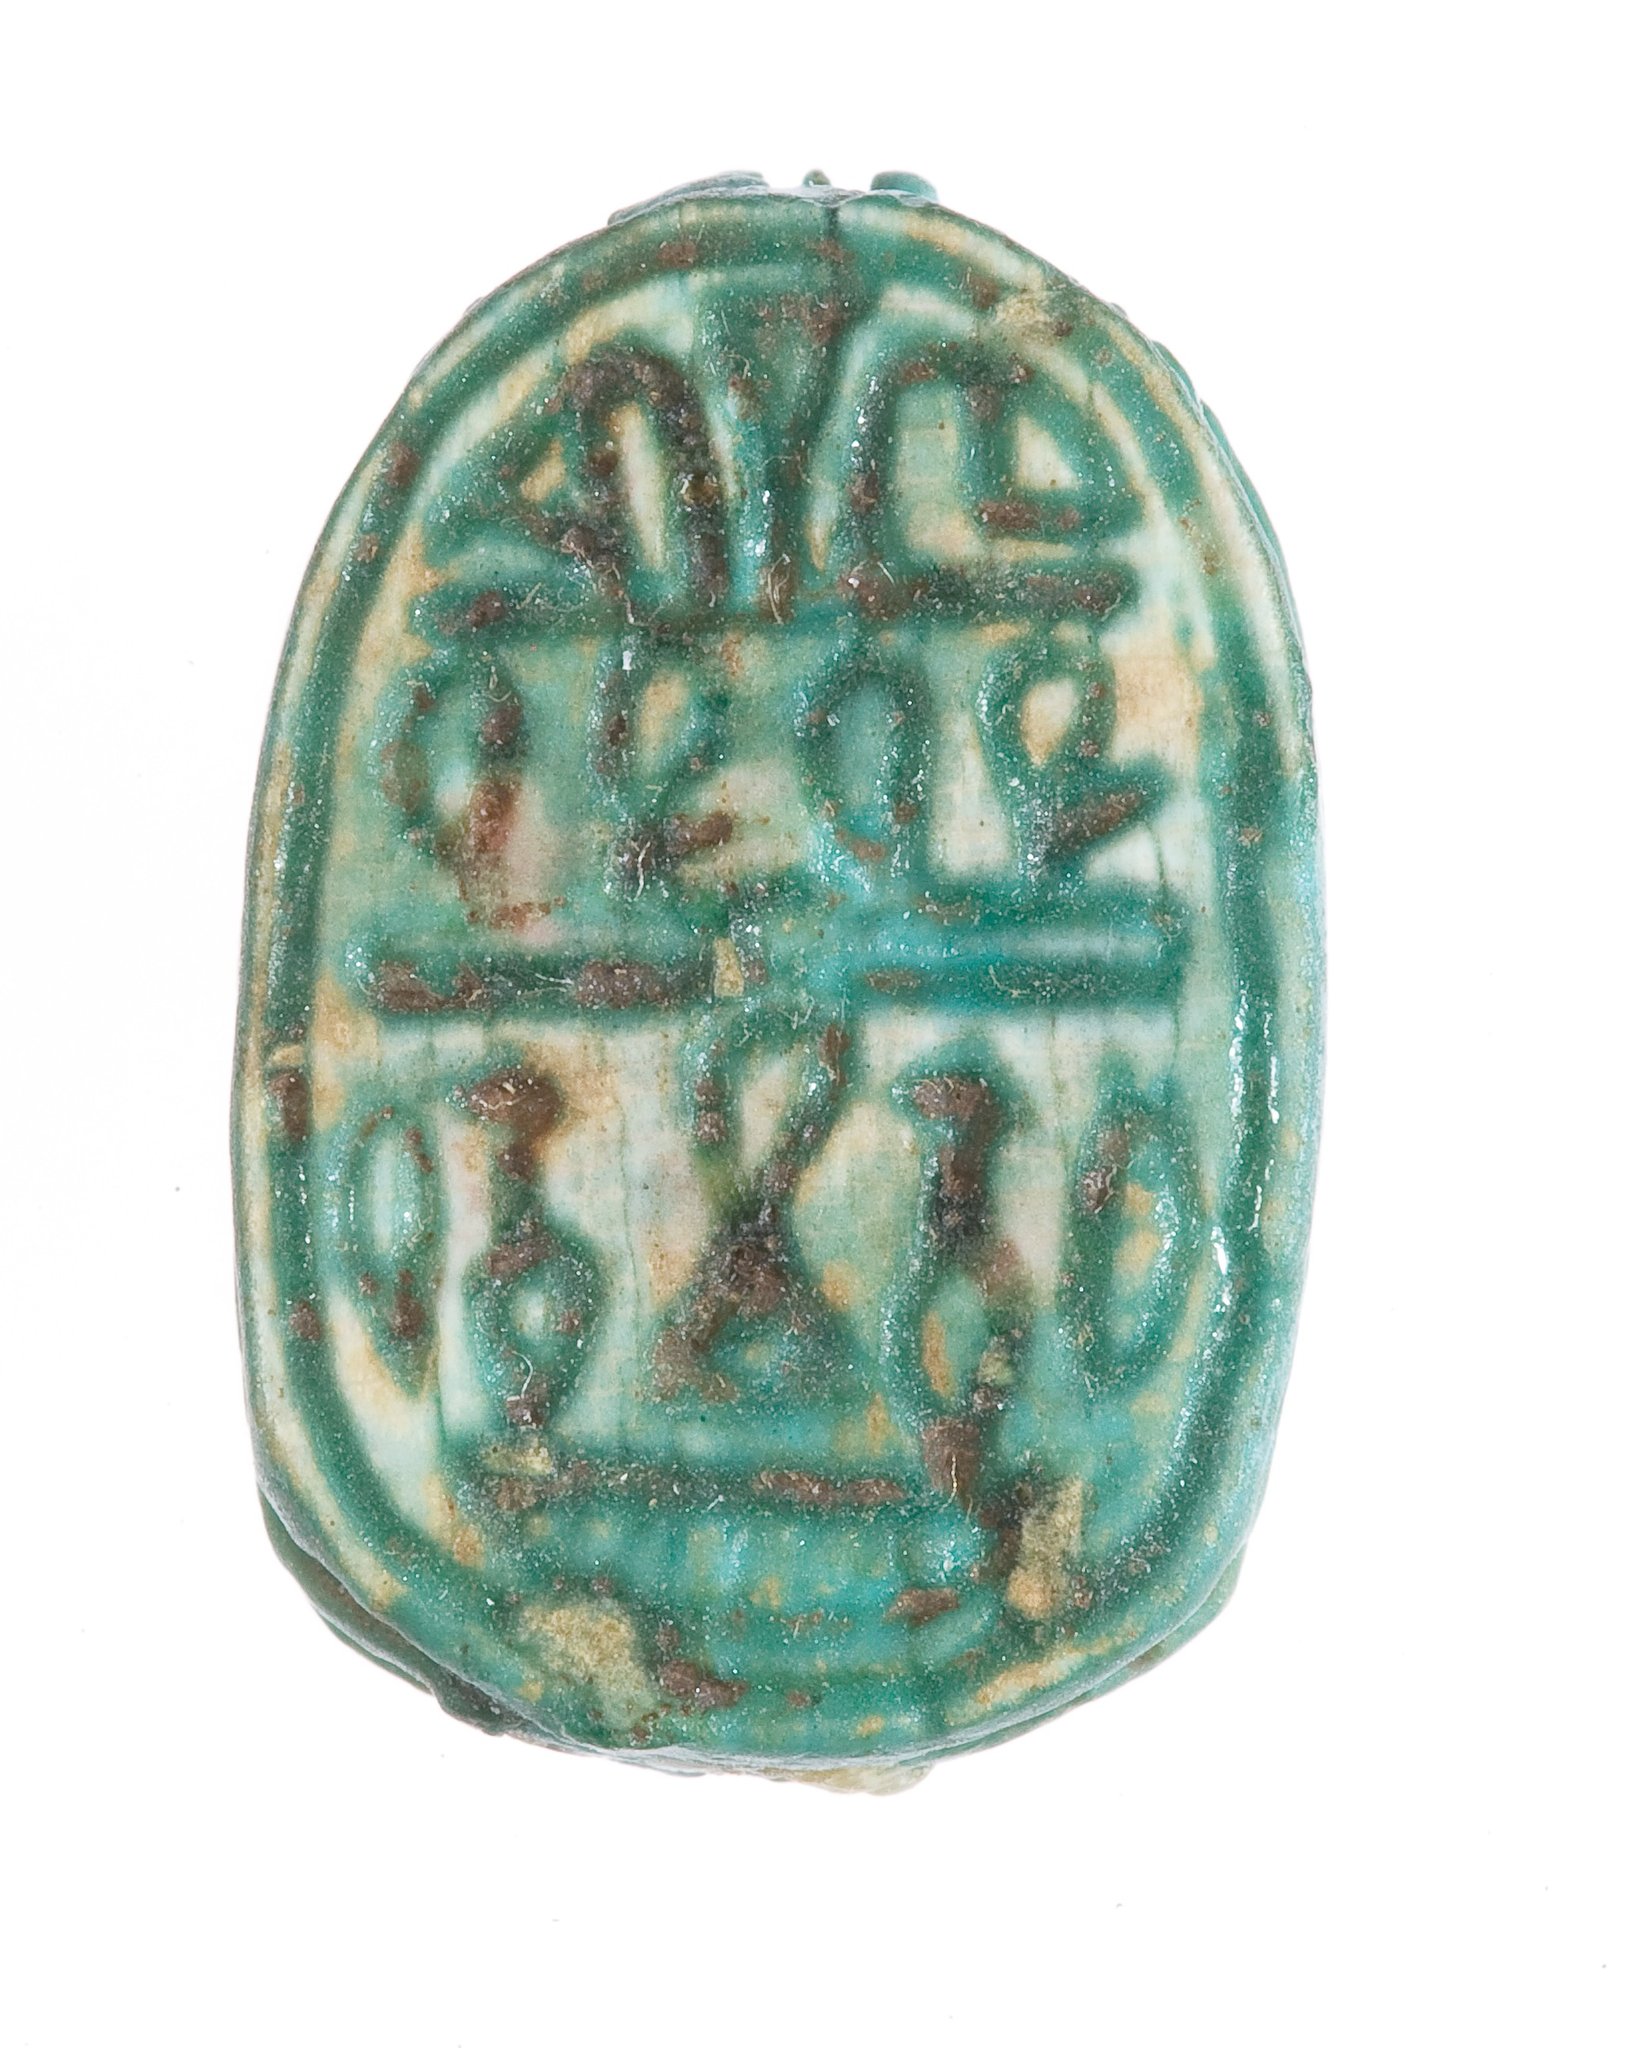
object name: scarab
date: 1550-1458 BCE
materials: stone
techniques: glazing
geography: egypt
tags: hieroglyphs,scarabs